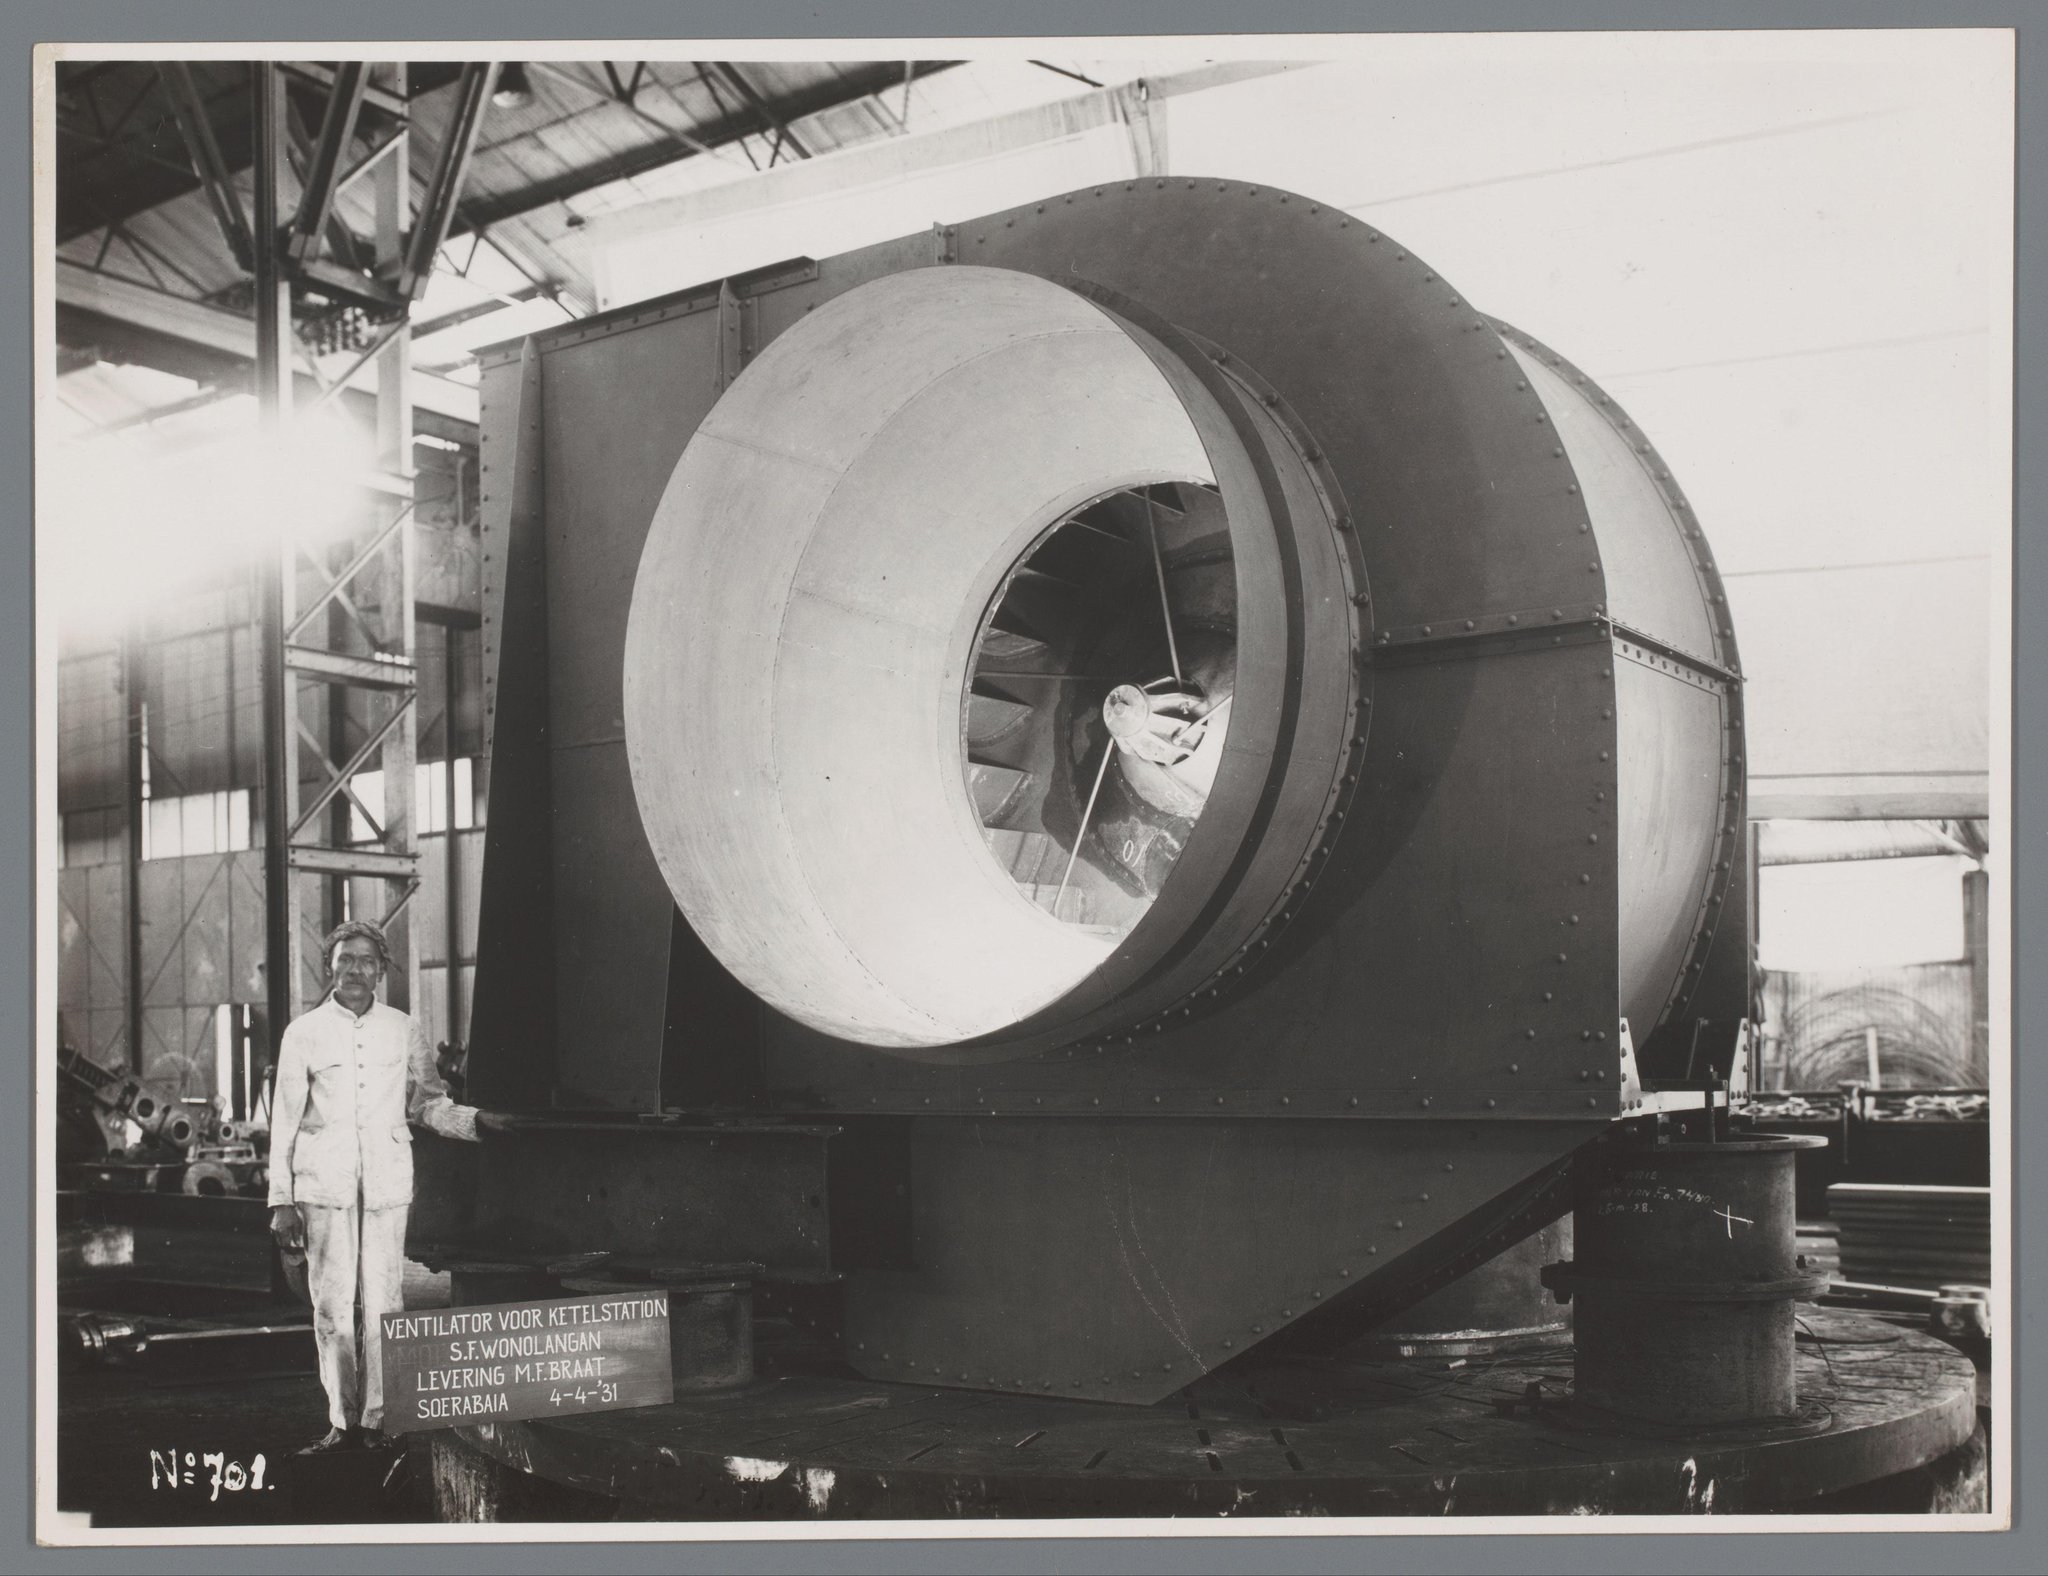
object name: photograph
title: Ventilator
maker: Anonymous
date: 1931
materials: photographic support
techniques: gelatin silver print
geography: surabaya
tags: colonial system, factory-interior, machine shop, machines; parts of machines; tools and appliances, java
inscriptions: date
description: Ventilator voor een ketelstation, vervaardigd in 1931 en bestemd voor de Suikerfabriek Wonolangan. Onderdeel van de multomap met foto's van machines van de N.V. Machinefabriek Braat te Soerabaja, Soekaboemi en Jogyakarta, uit de periode 1908-1942.